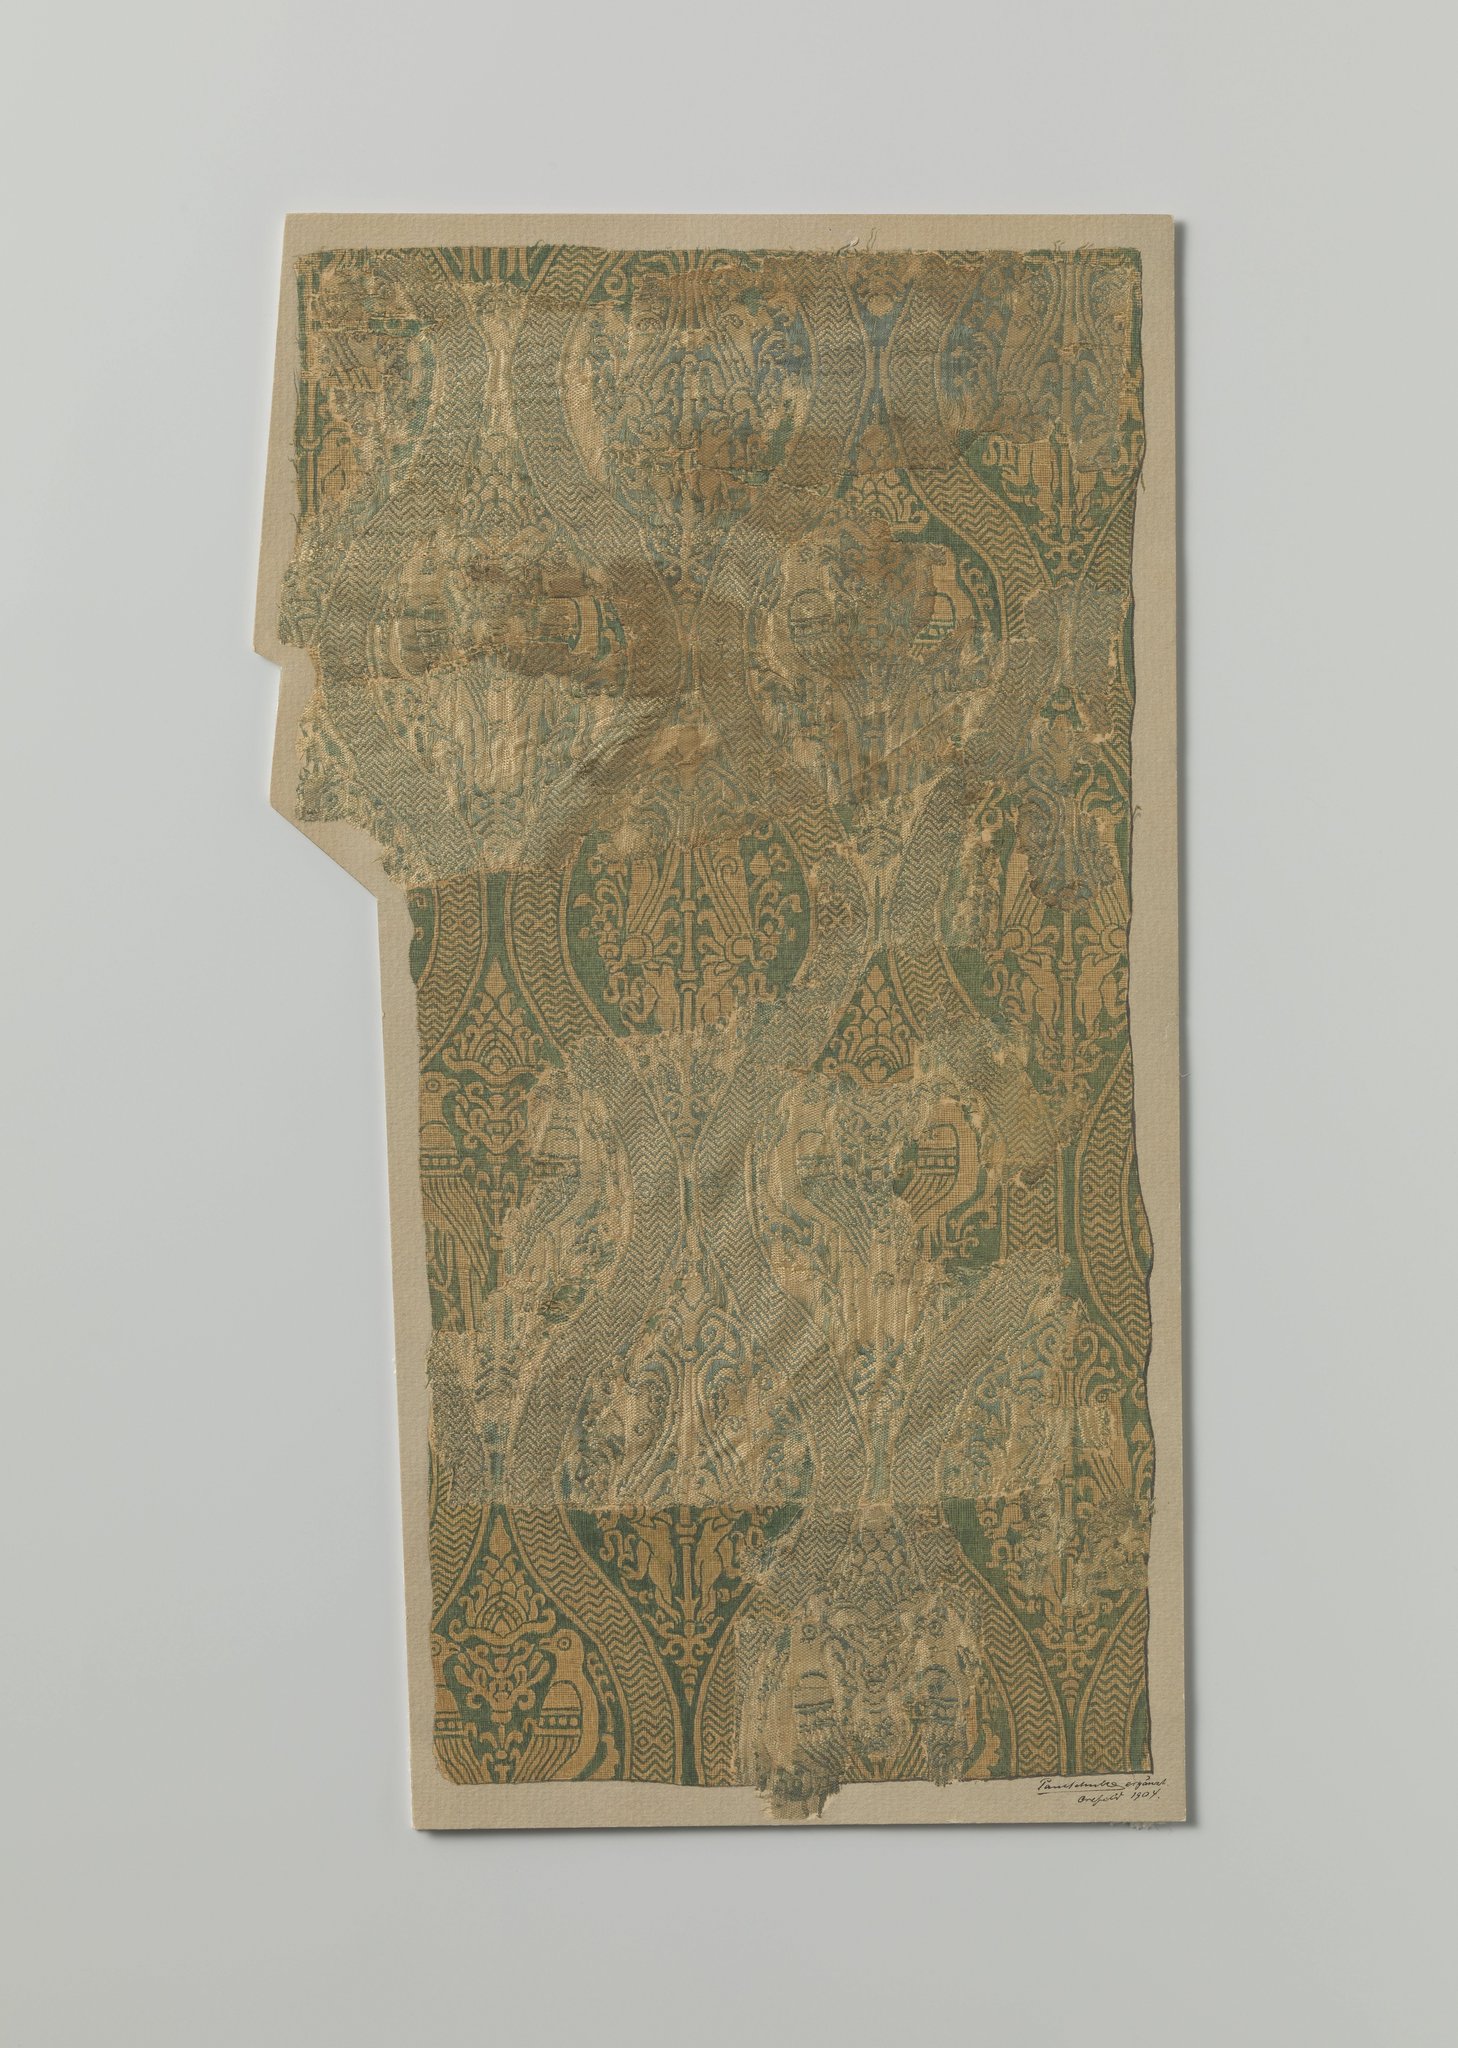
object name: silk textile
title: Fragment zijdeweefsel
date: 1904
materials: silk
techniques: samite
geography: krefeld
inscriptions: signature and date: ‘Paul Schulze ergänzt Crefeld 1904’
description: Fragment van twee op patroon aan elkaar geplakte stukken groene zijde met patroon in geel van bandslingers met kepermotief die spitsovalen vormen. In de spitsovalen afwisselend naar elkaar toegewende gestileerde vogels en bladornamenten. Patroon is hier en daar bijgetekend.